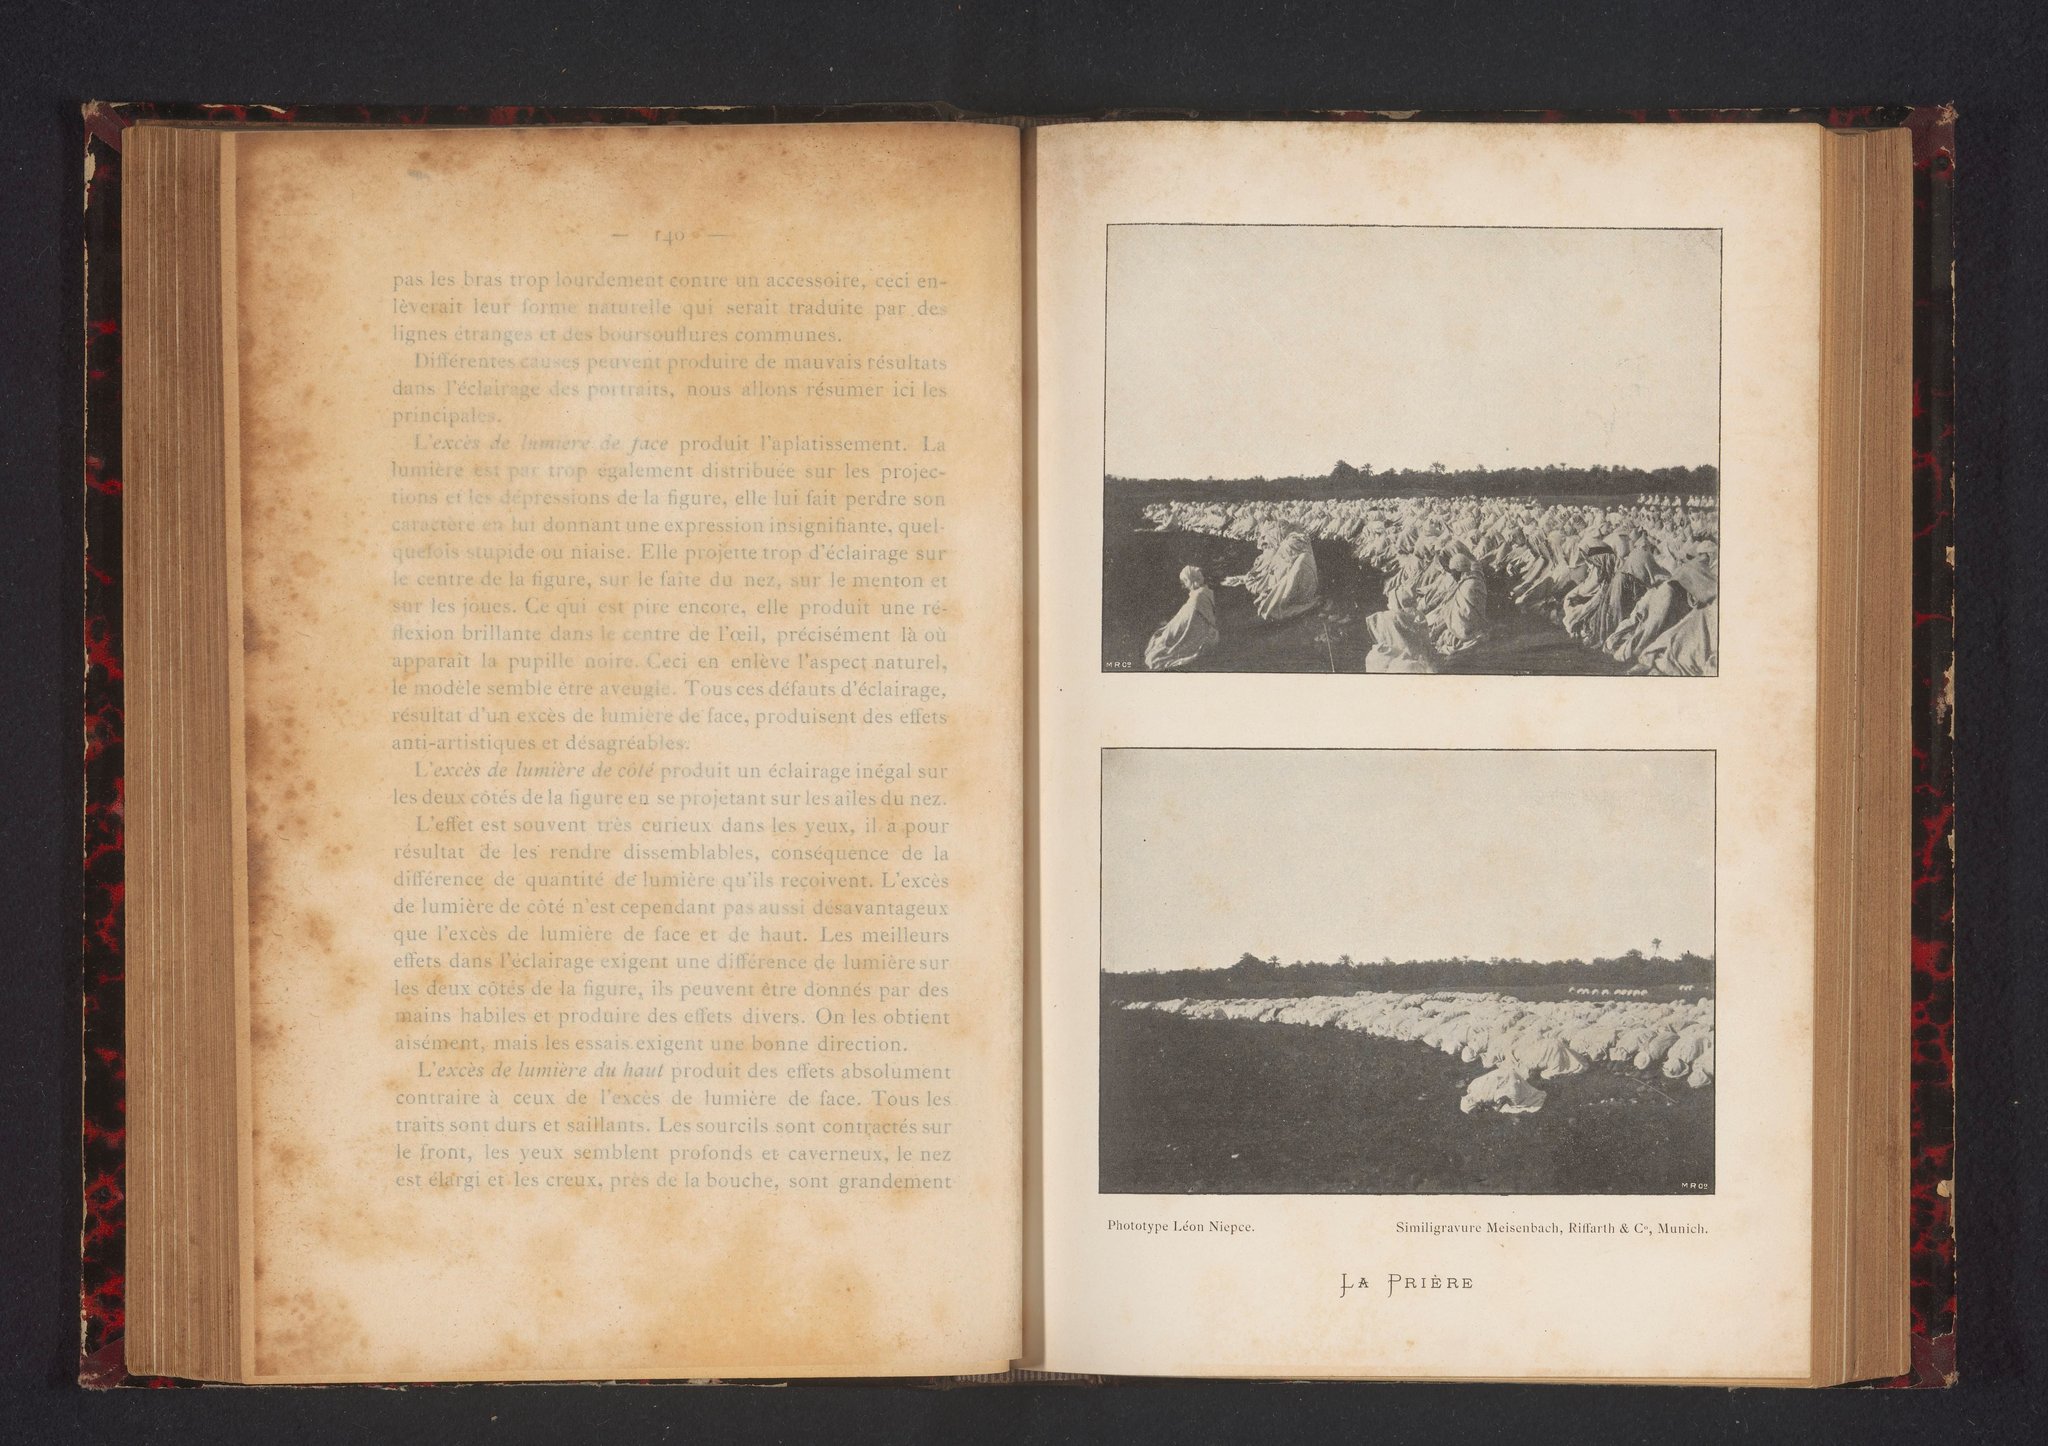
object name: page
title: La Prière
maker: léon niepce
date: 1893-1898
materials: paper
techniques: autotype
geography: munich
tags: prayer ~ islam, mohammedanism